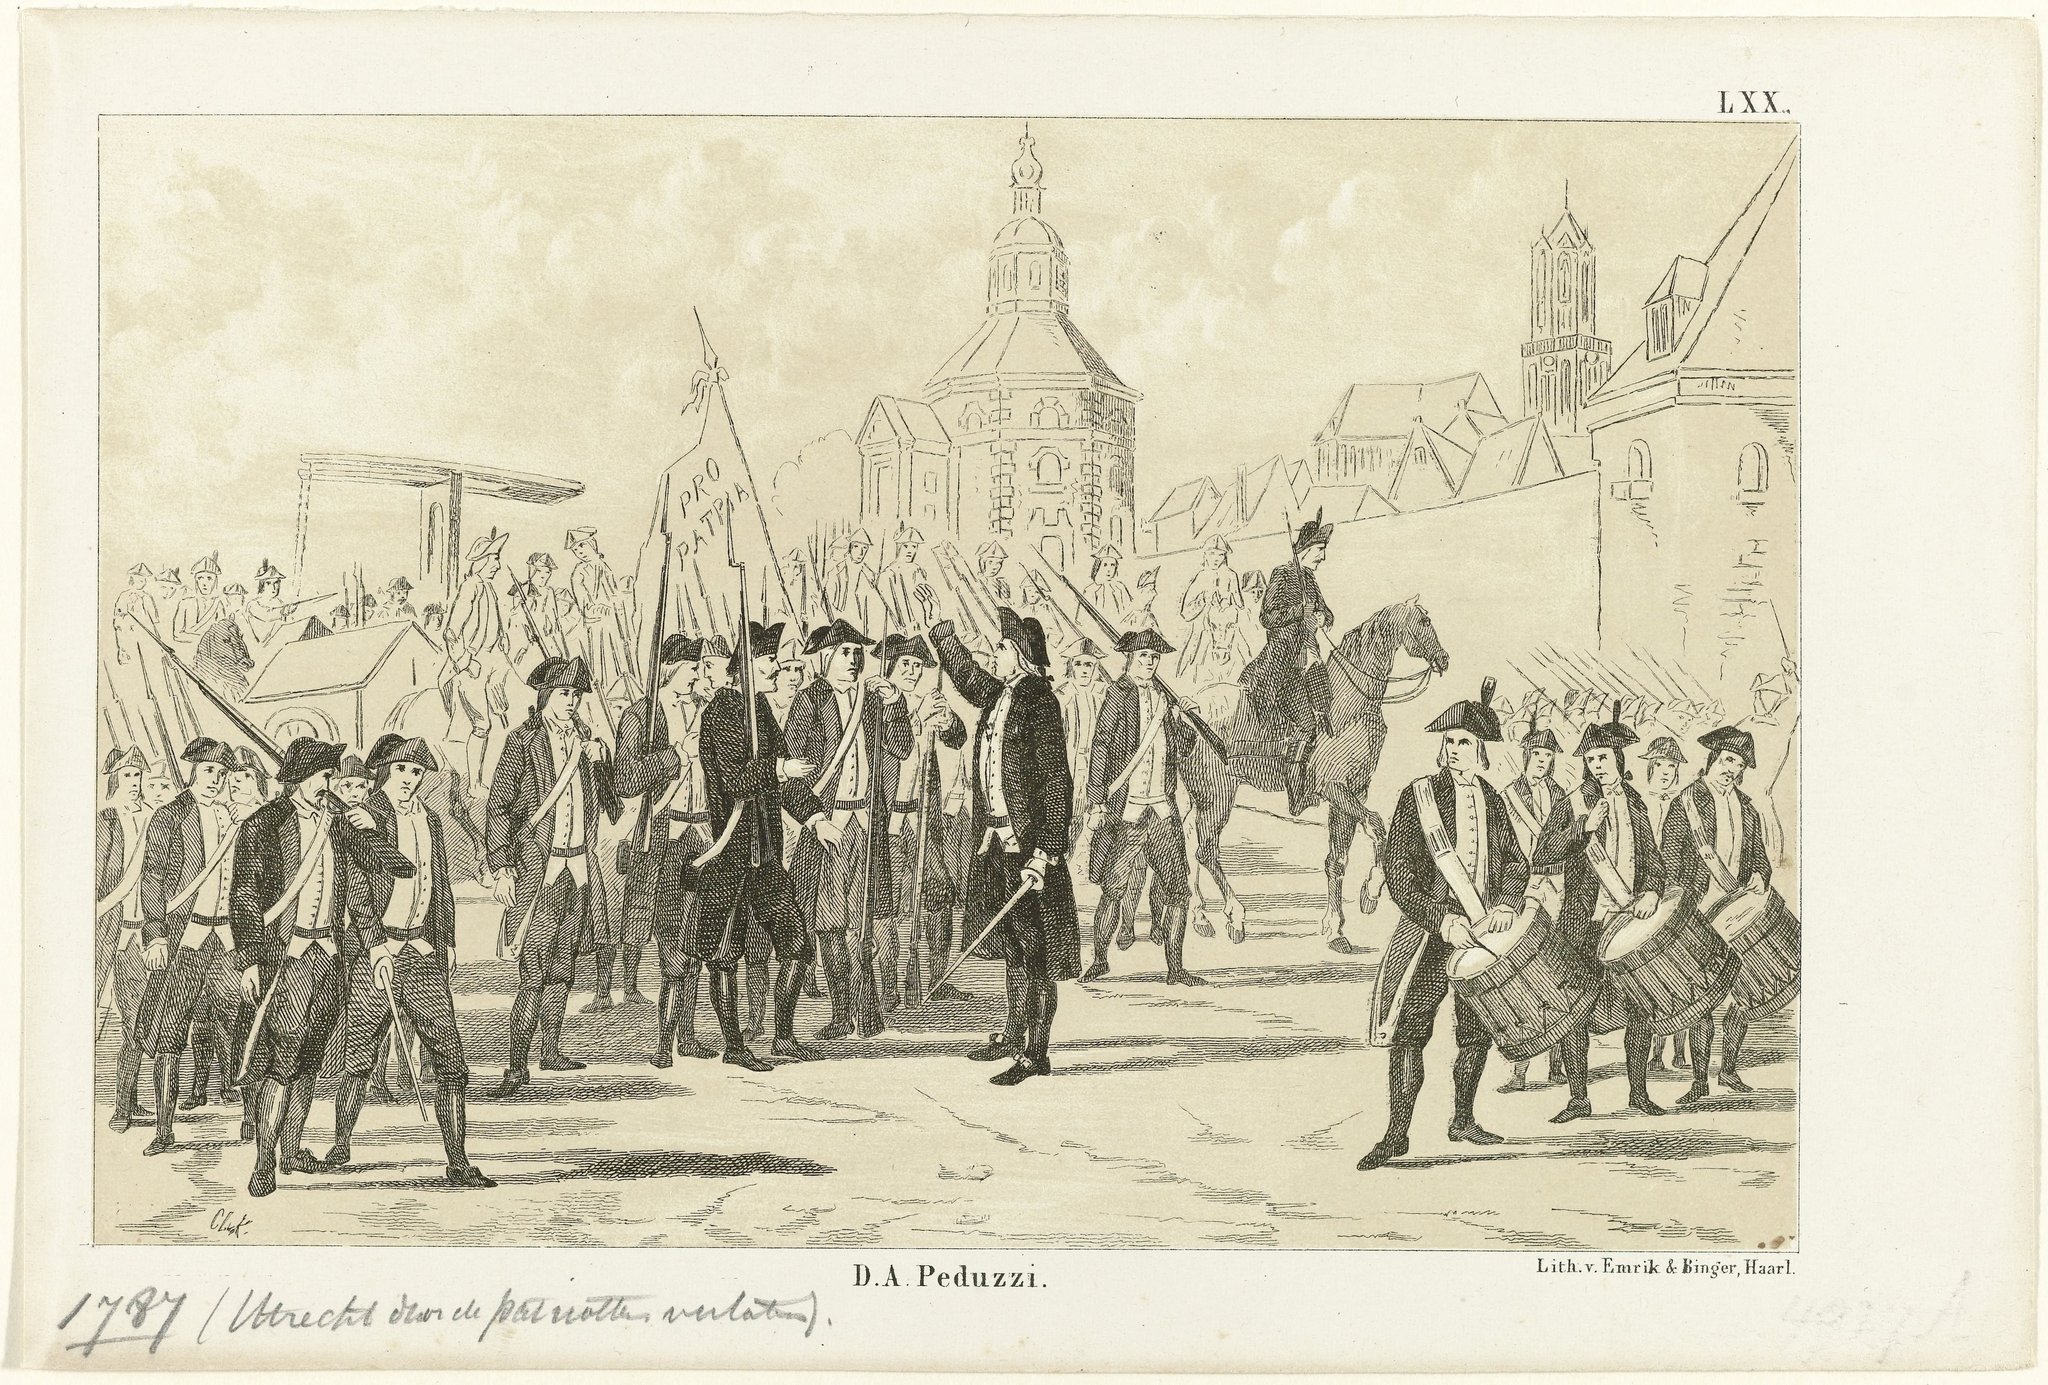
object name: history print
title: Utrecht door de patriotten verlaten, 1787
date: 1853-1861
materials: paper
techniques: tone lithography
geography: netherlands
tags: putting the enemy to flight - hh - being put to flight, fleeing (+ citizen soldiery, civil guard, citizen militia), utrecht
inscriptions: collector's mark: Lugt 2228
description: Gebruikt als illustratie in: Jacob van Lennep, De geschiedenis des vaderlands in schetsen en afbeeldingen, Binger, Amsterdam 1855-1861, 8 delen, pl. LXX. Dit nummer is een door het RPK toegevoegd nummer en staat niet in Frederik Muller, het werk waar de prent voor is gemaakt of uit afkomstig is, staat wel vermeld in Frederik Muller.